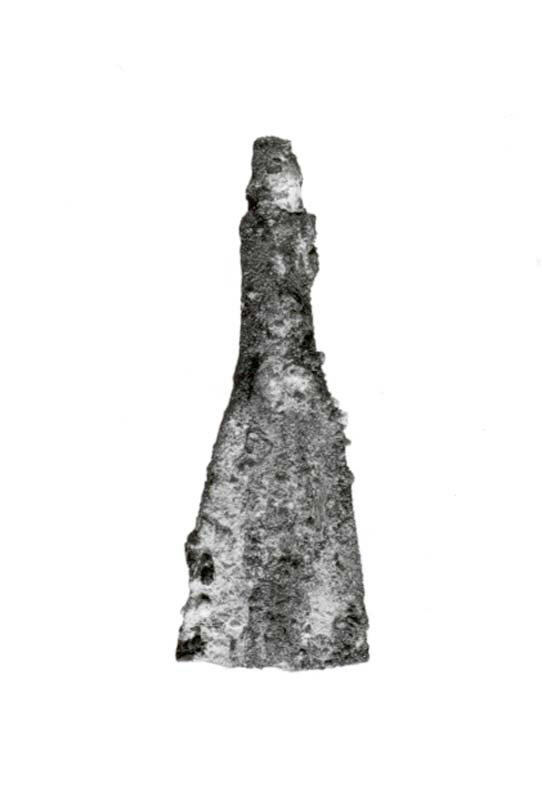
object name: arrowhead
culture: iranian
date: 900-801 BCE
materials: iron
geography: iran